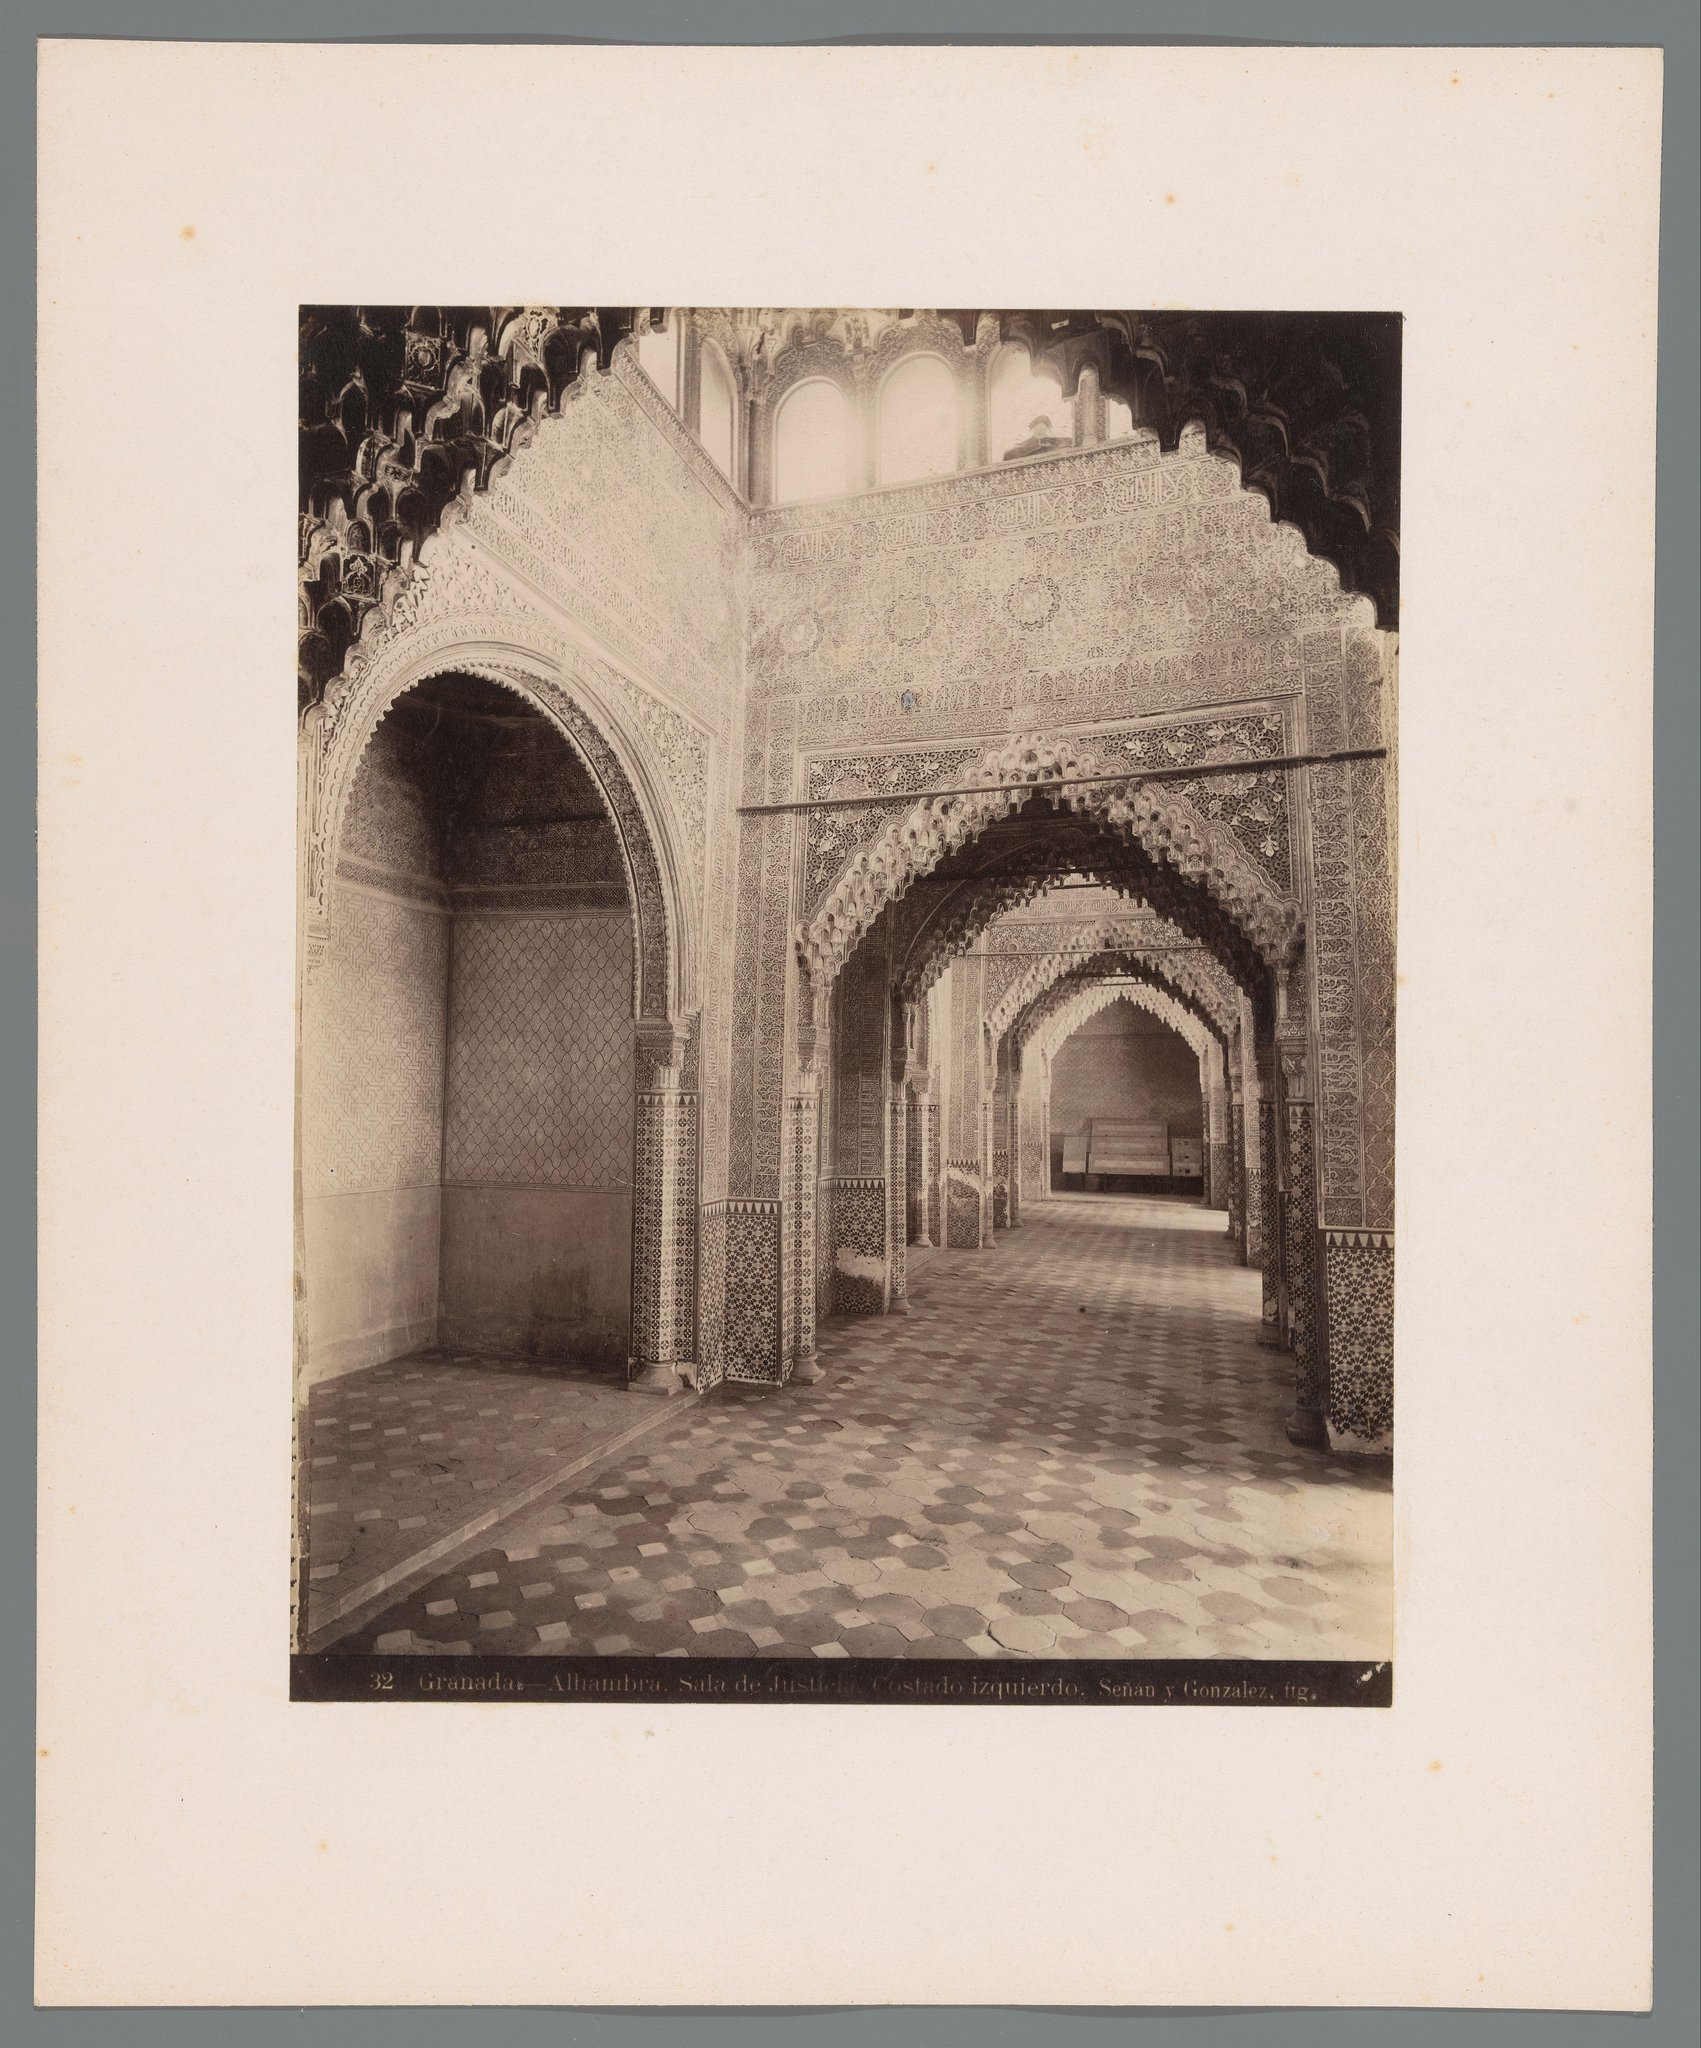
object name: photograph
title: Sala de la Justicia in het Alhambra in Granada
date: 1880-1900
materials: cardboard, paper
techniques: albumen print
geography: granada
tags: interior of the house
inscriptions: number: ‘32’